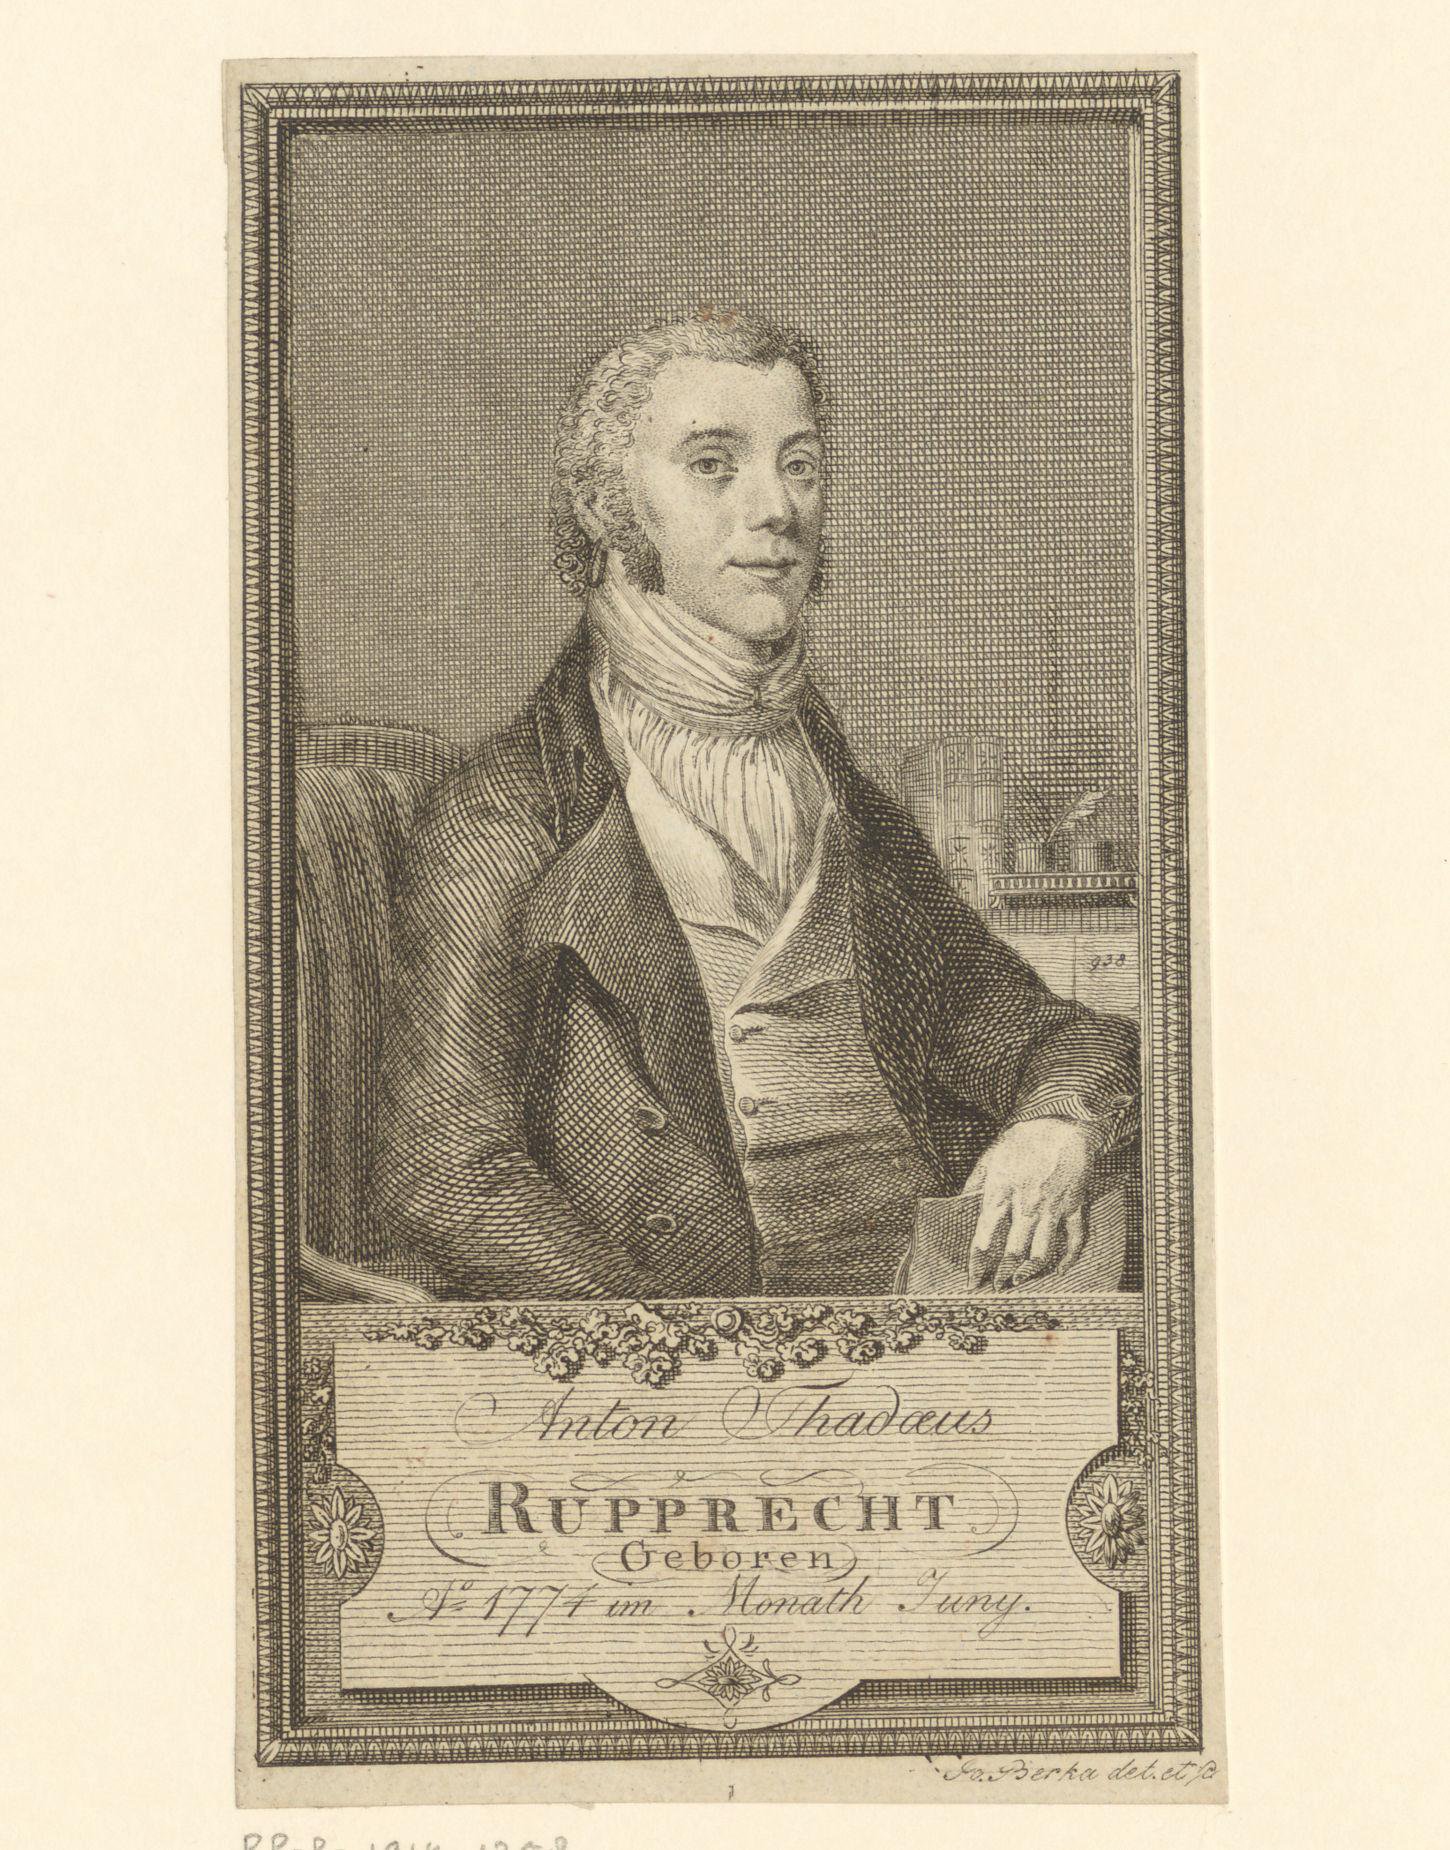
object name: print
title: Portret van Anton Thadaeus Rupprecht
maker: johann berka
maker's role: painter, print maker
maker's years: 1759-1838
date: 1769-1838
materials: paper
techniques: engraving, etching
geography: prague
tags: historical persons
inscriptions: collector's mark: Lugt 2228